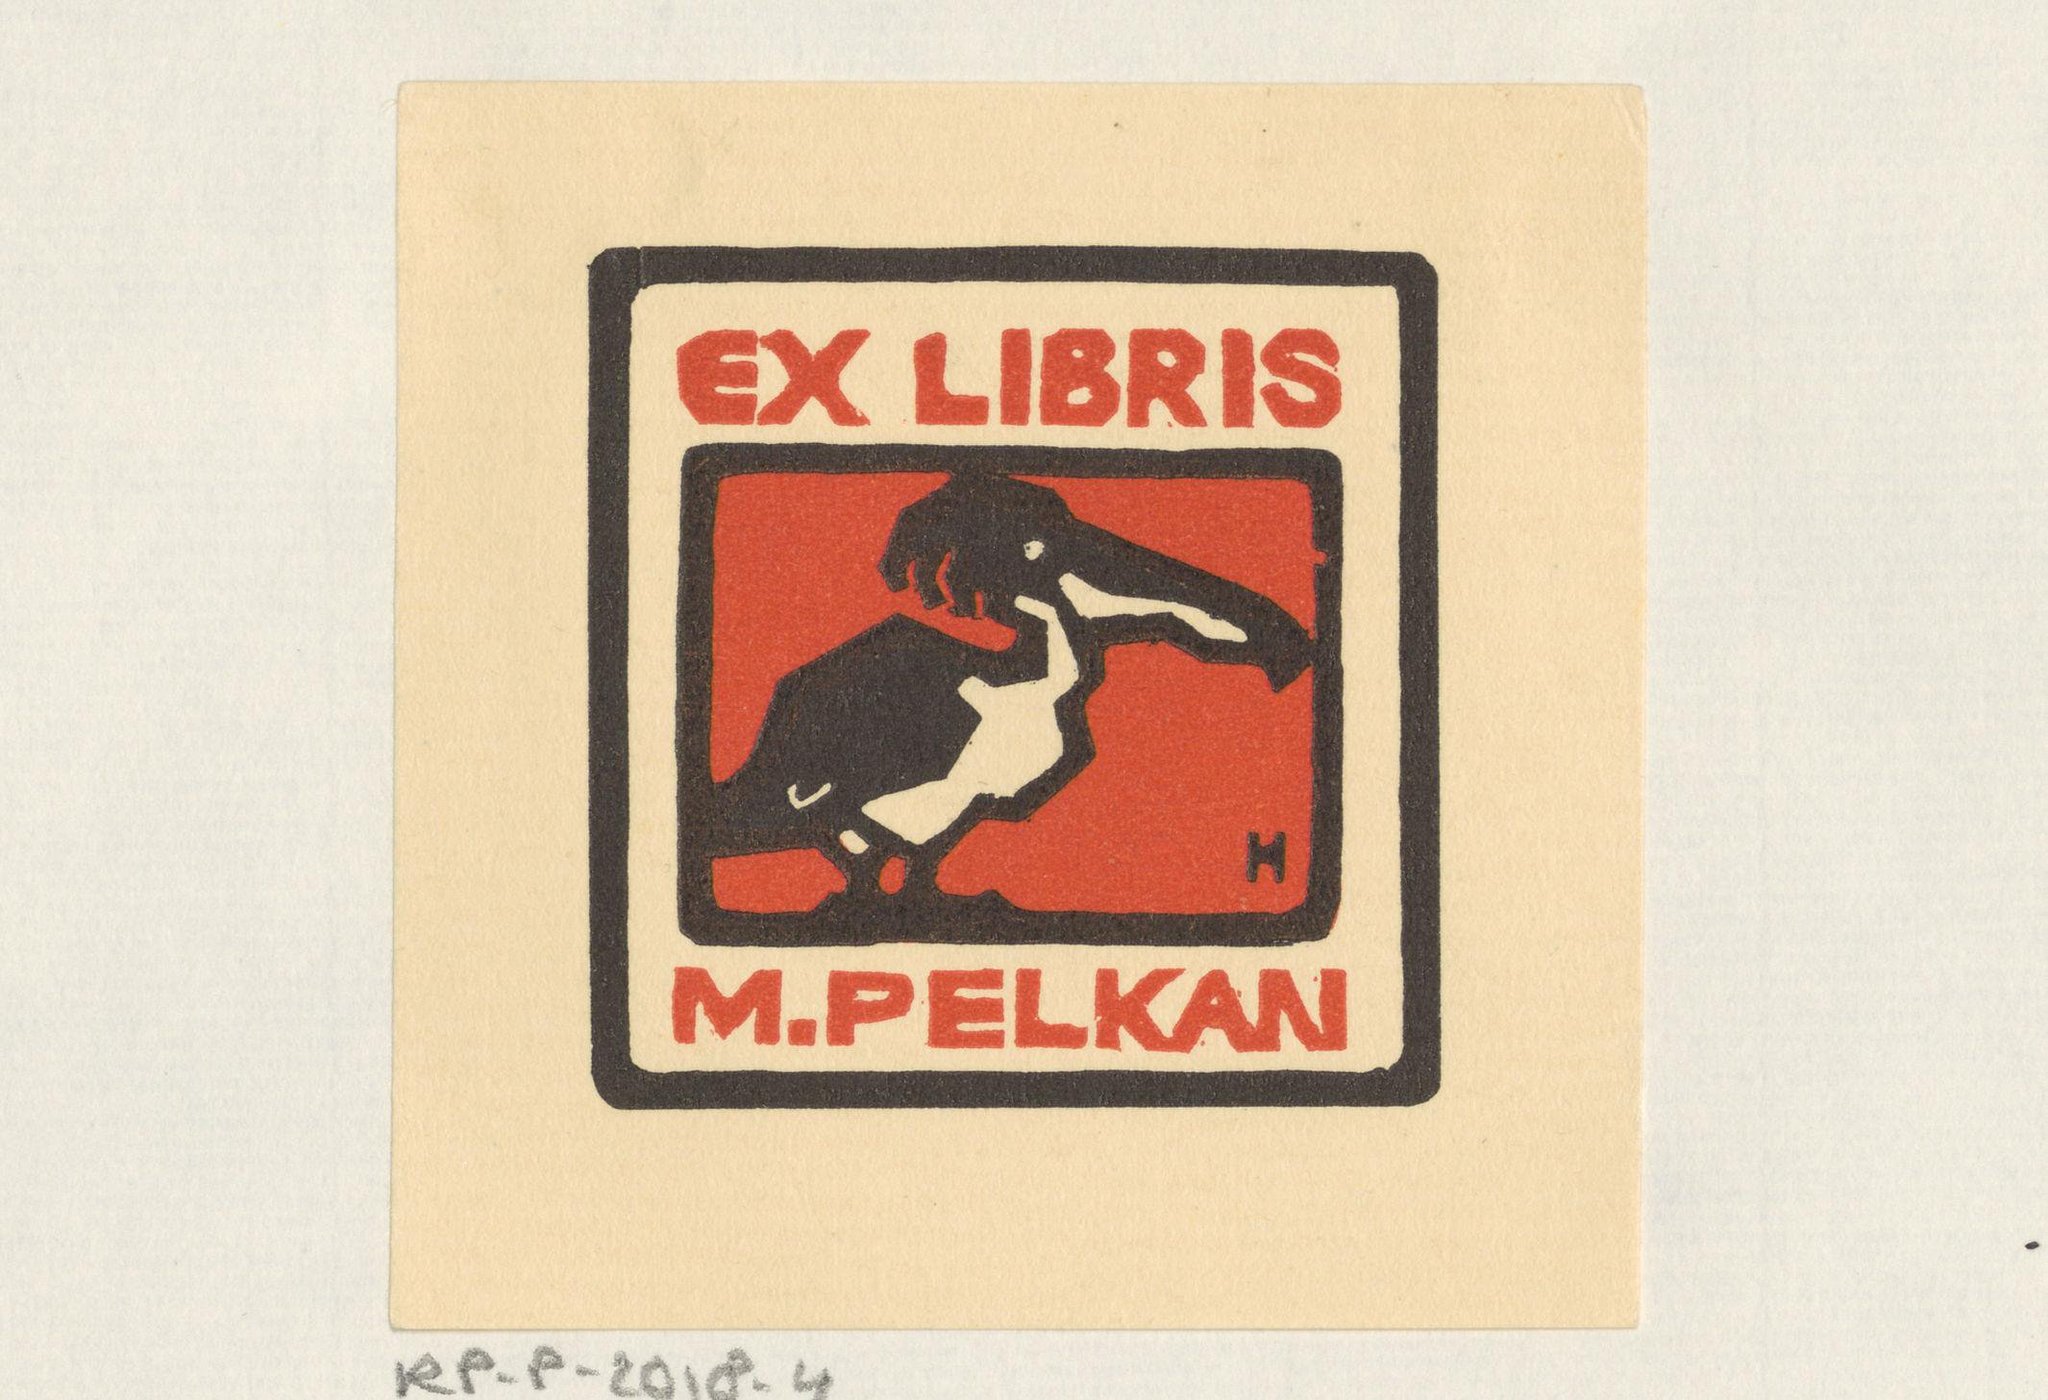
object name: bookplate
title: Ex libris van M. Pelkan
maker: rolf von hoerschelmann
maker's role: draughtsman, print maker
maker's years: 1885-1947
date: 1895-1947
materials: paper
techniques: linocut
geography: germany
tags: water-birds: pelican